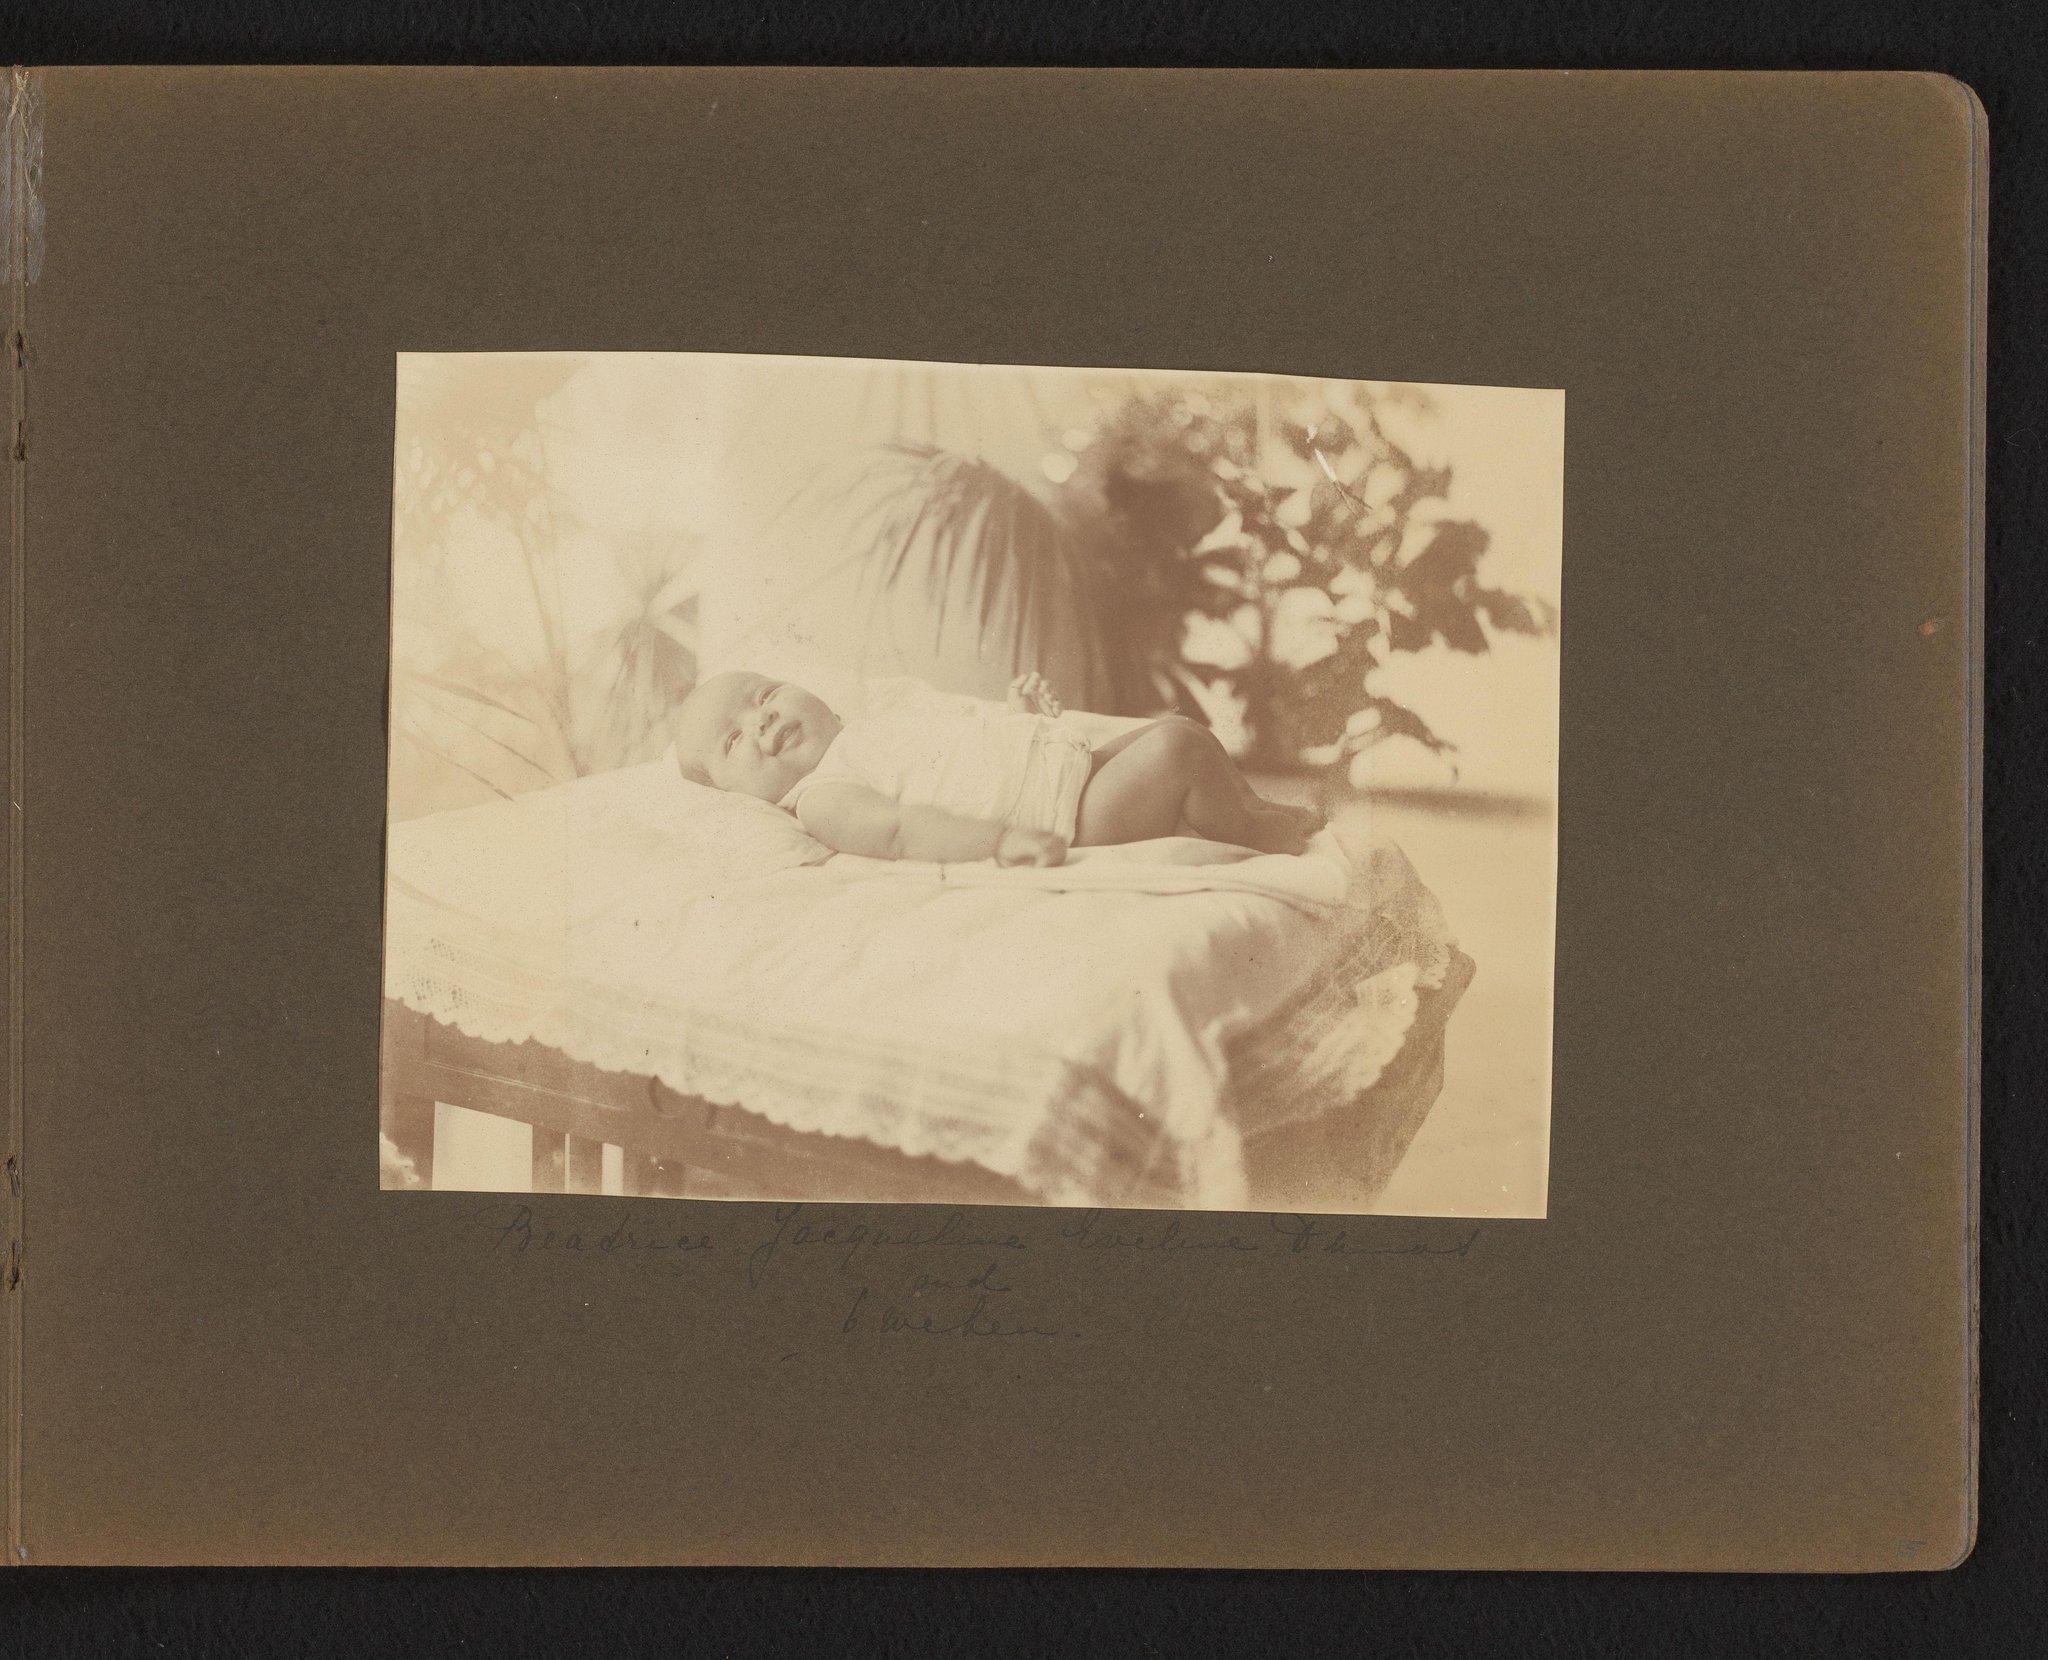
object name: album leaf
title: Eef als baby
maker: frédéric gabriël dumas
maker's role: engineer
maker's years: 1886-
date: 1904-1915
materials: cardboard, photographic support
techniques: gelatin silver print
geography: dutch east indies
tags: surabaya, beatrice jacqueline eveline dumas, female infant, family life at home, infant, baby, dutch east indies, the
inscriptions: annotation: ‘Beatrice Jacqueline Eveline Dumas oud 6 weken’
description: Blad met een foto van Eef Dumas als baby van zes weken. Onderdeel van het fotoalbum over de kindertijd van Han (geboren sept-okt 1910) en Eef Dumas (geboren februari 1915) in Nederlands-Indië.